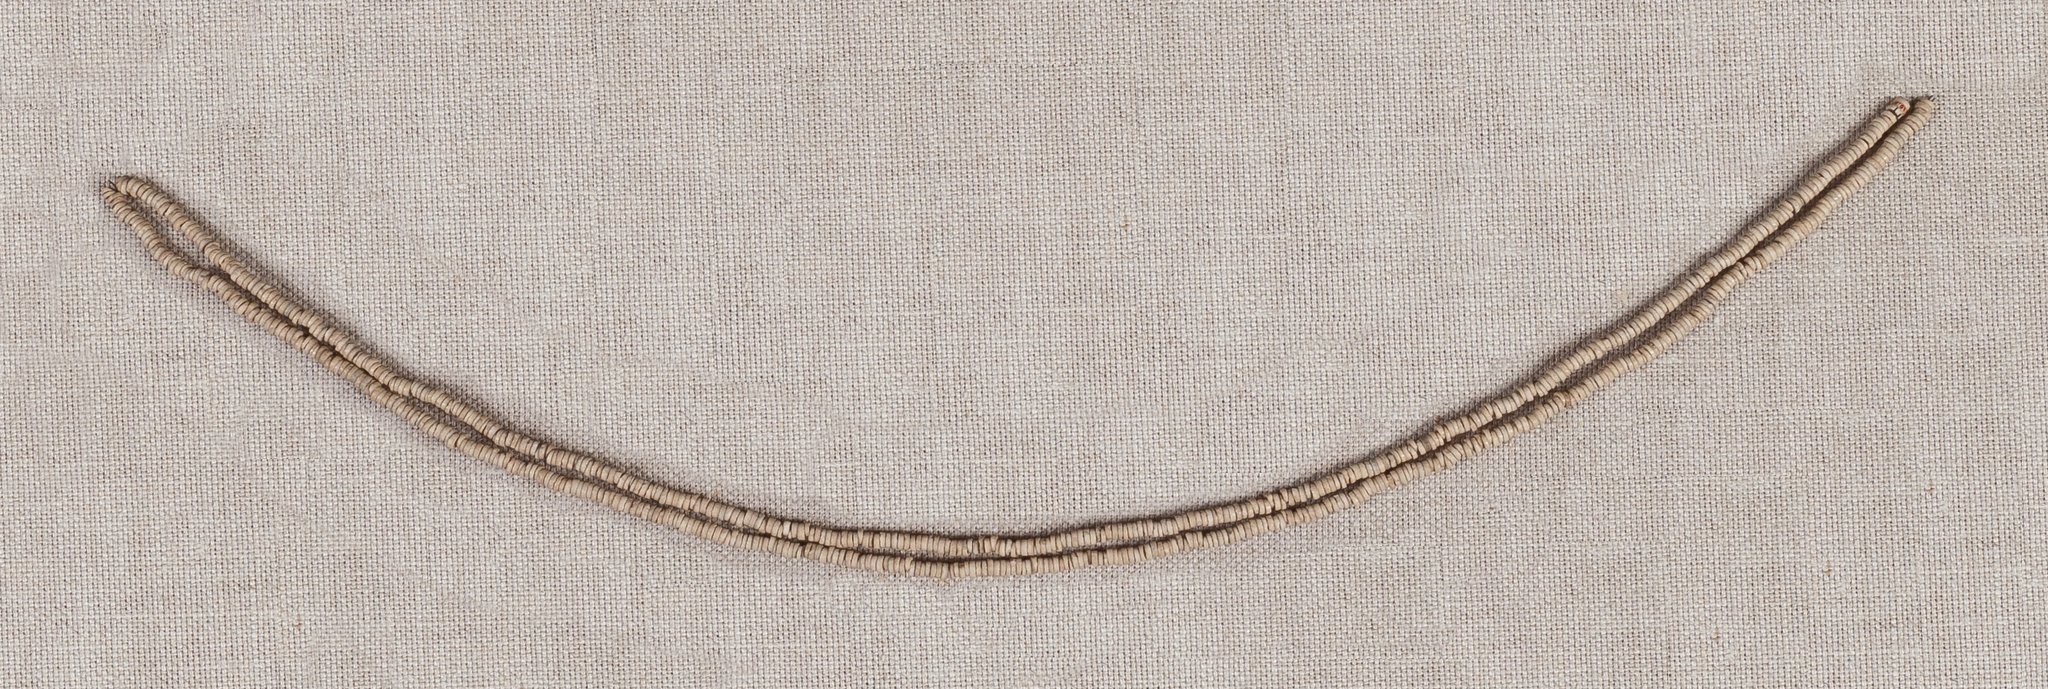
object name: necklace, bead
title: Strng of beads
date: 1981-1295 BCE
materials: shell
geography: egypt